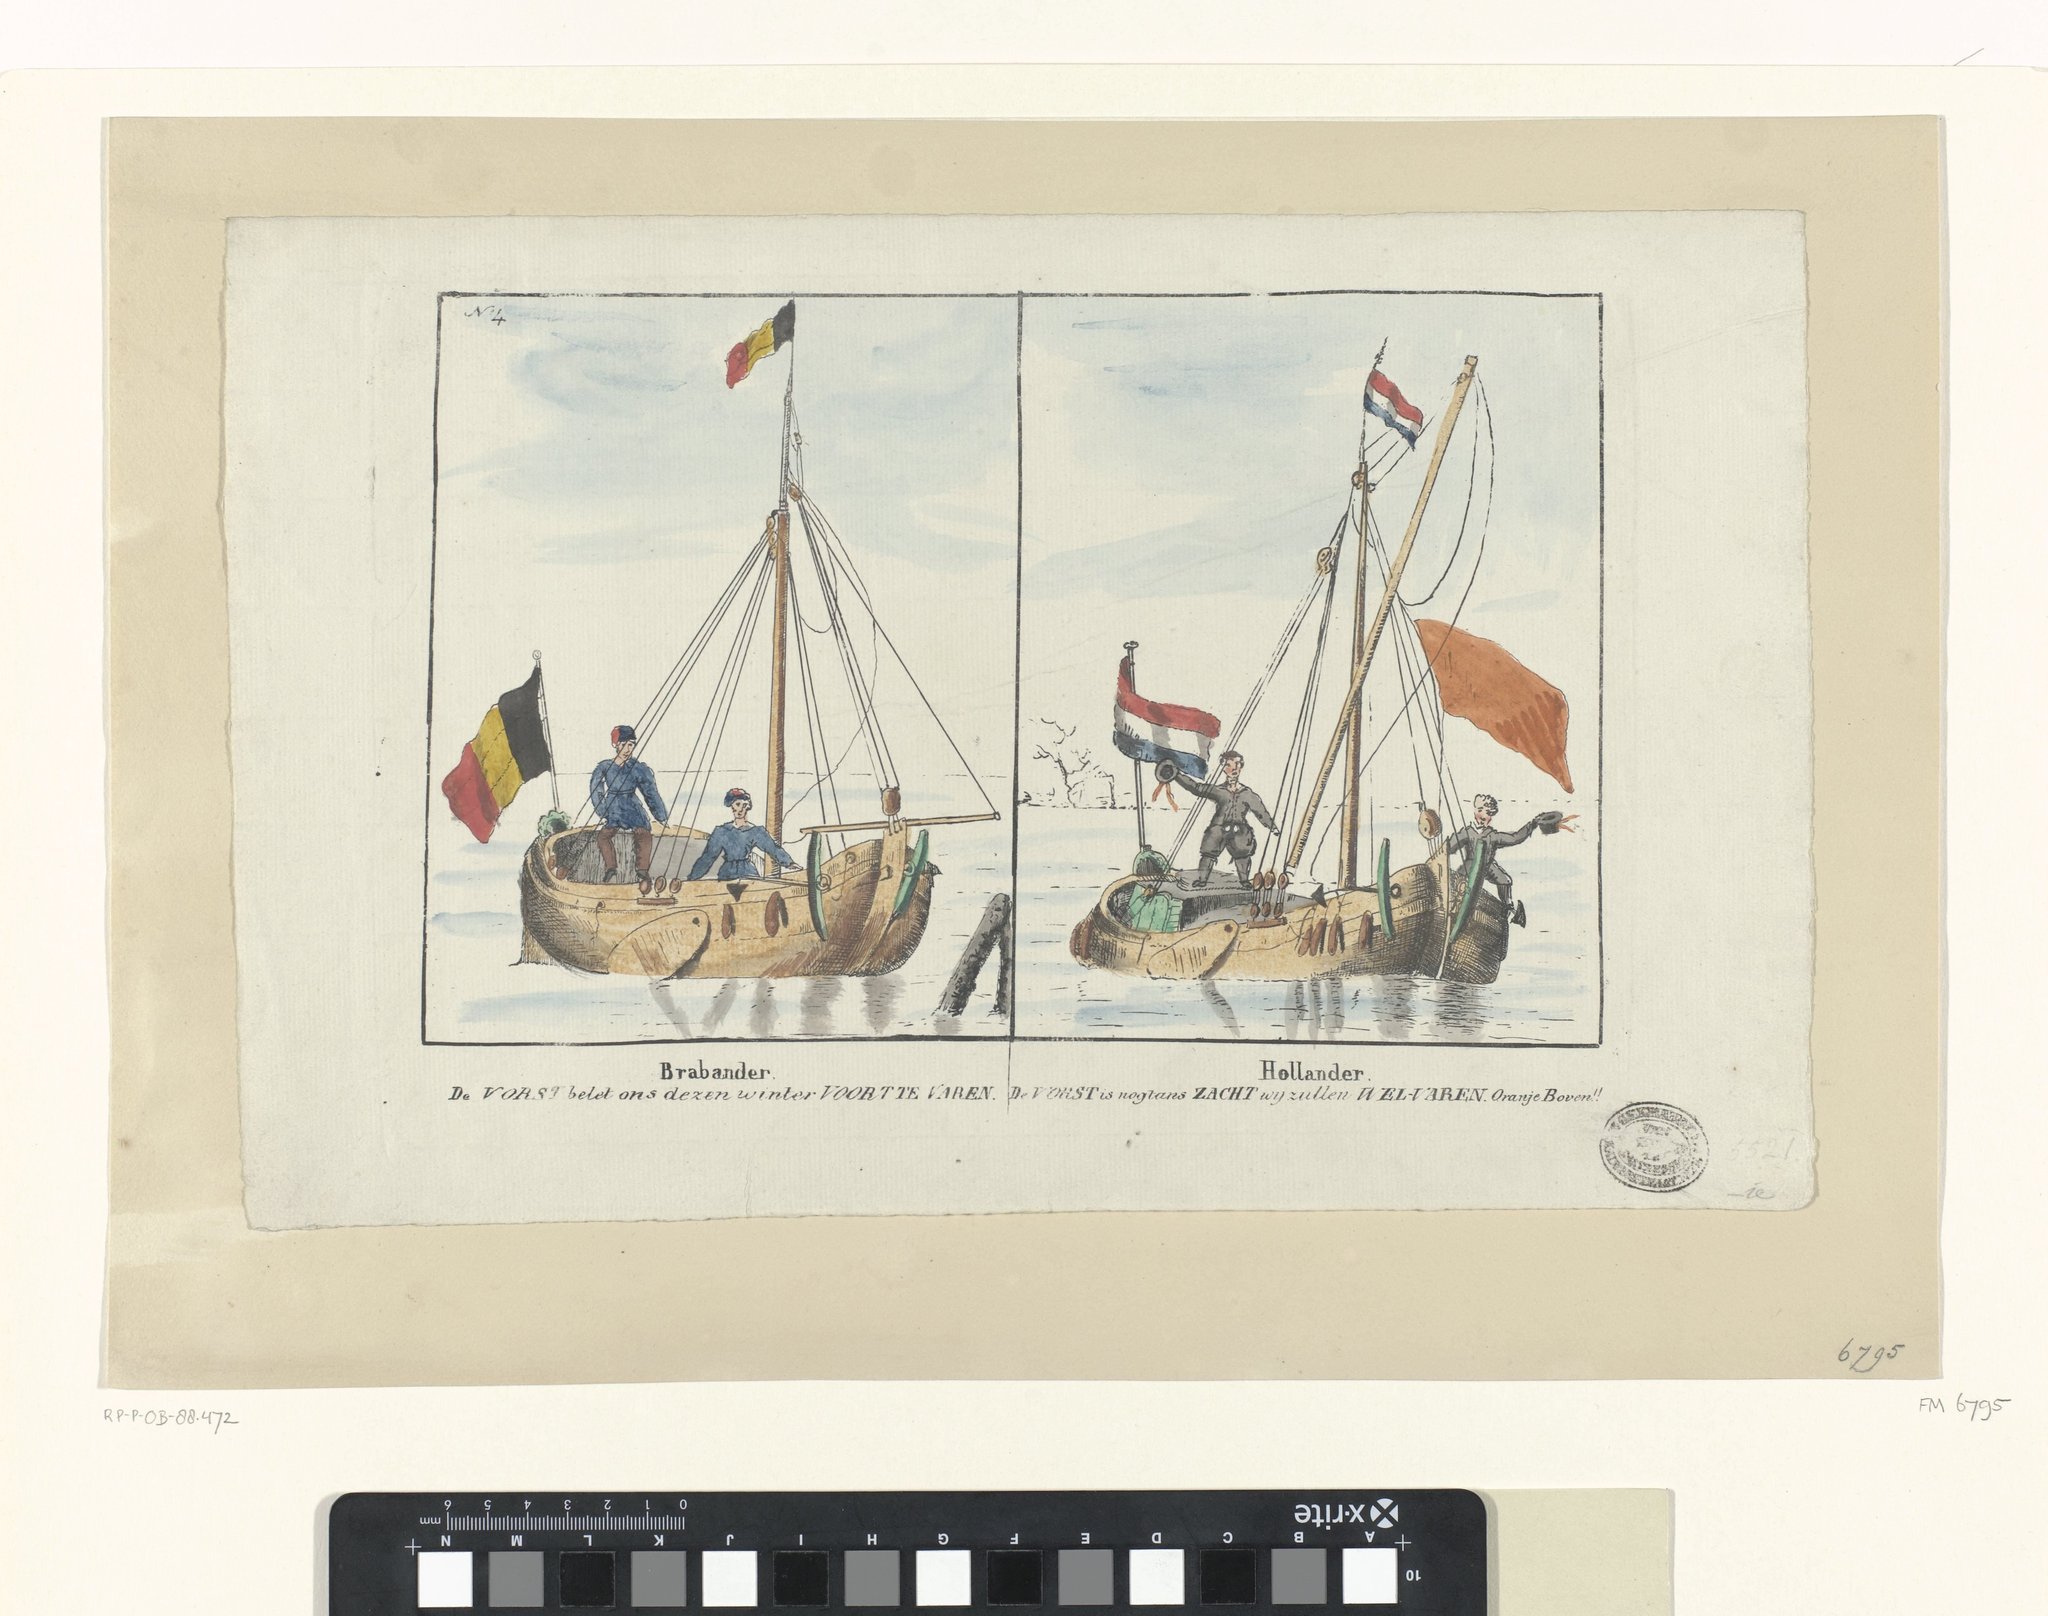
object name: cartoon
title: Brabander en Hollander, 1831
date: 1831-1832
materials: paper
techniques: hand coloring, lithograph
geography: netherlands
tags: the hague, berlin, william i of the netherlands, ships (in general) (+ propulsion of vehicle, ship, etc. by wind), ice ~ freezing weather, ice ~ state of water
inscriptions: collector's mark: Lugt 2228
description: Spotprent op de tegenspoed voor de Belgen en de voorspoed voor de Hollanders, 1831. Links de 'Brabander', een scheepje met twee Belgen in blauwe werkmanskielen dat vast zit in het ijs. Rechts de 'Hollander', een scheepje met twee vrolijke Nederlandse matrozen dat vrij door kan varen. In de onderschriften verwijzingen naar de 'vorst'.